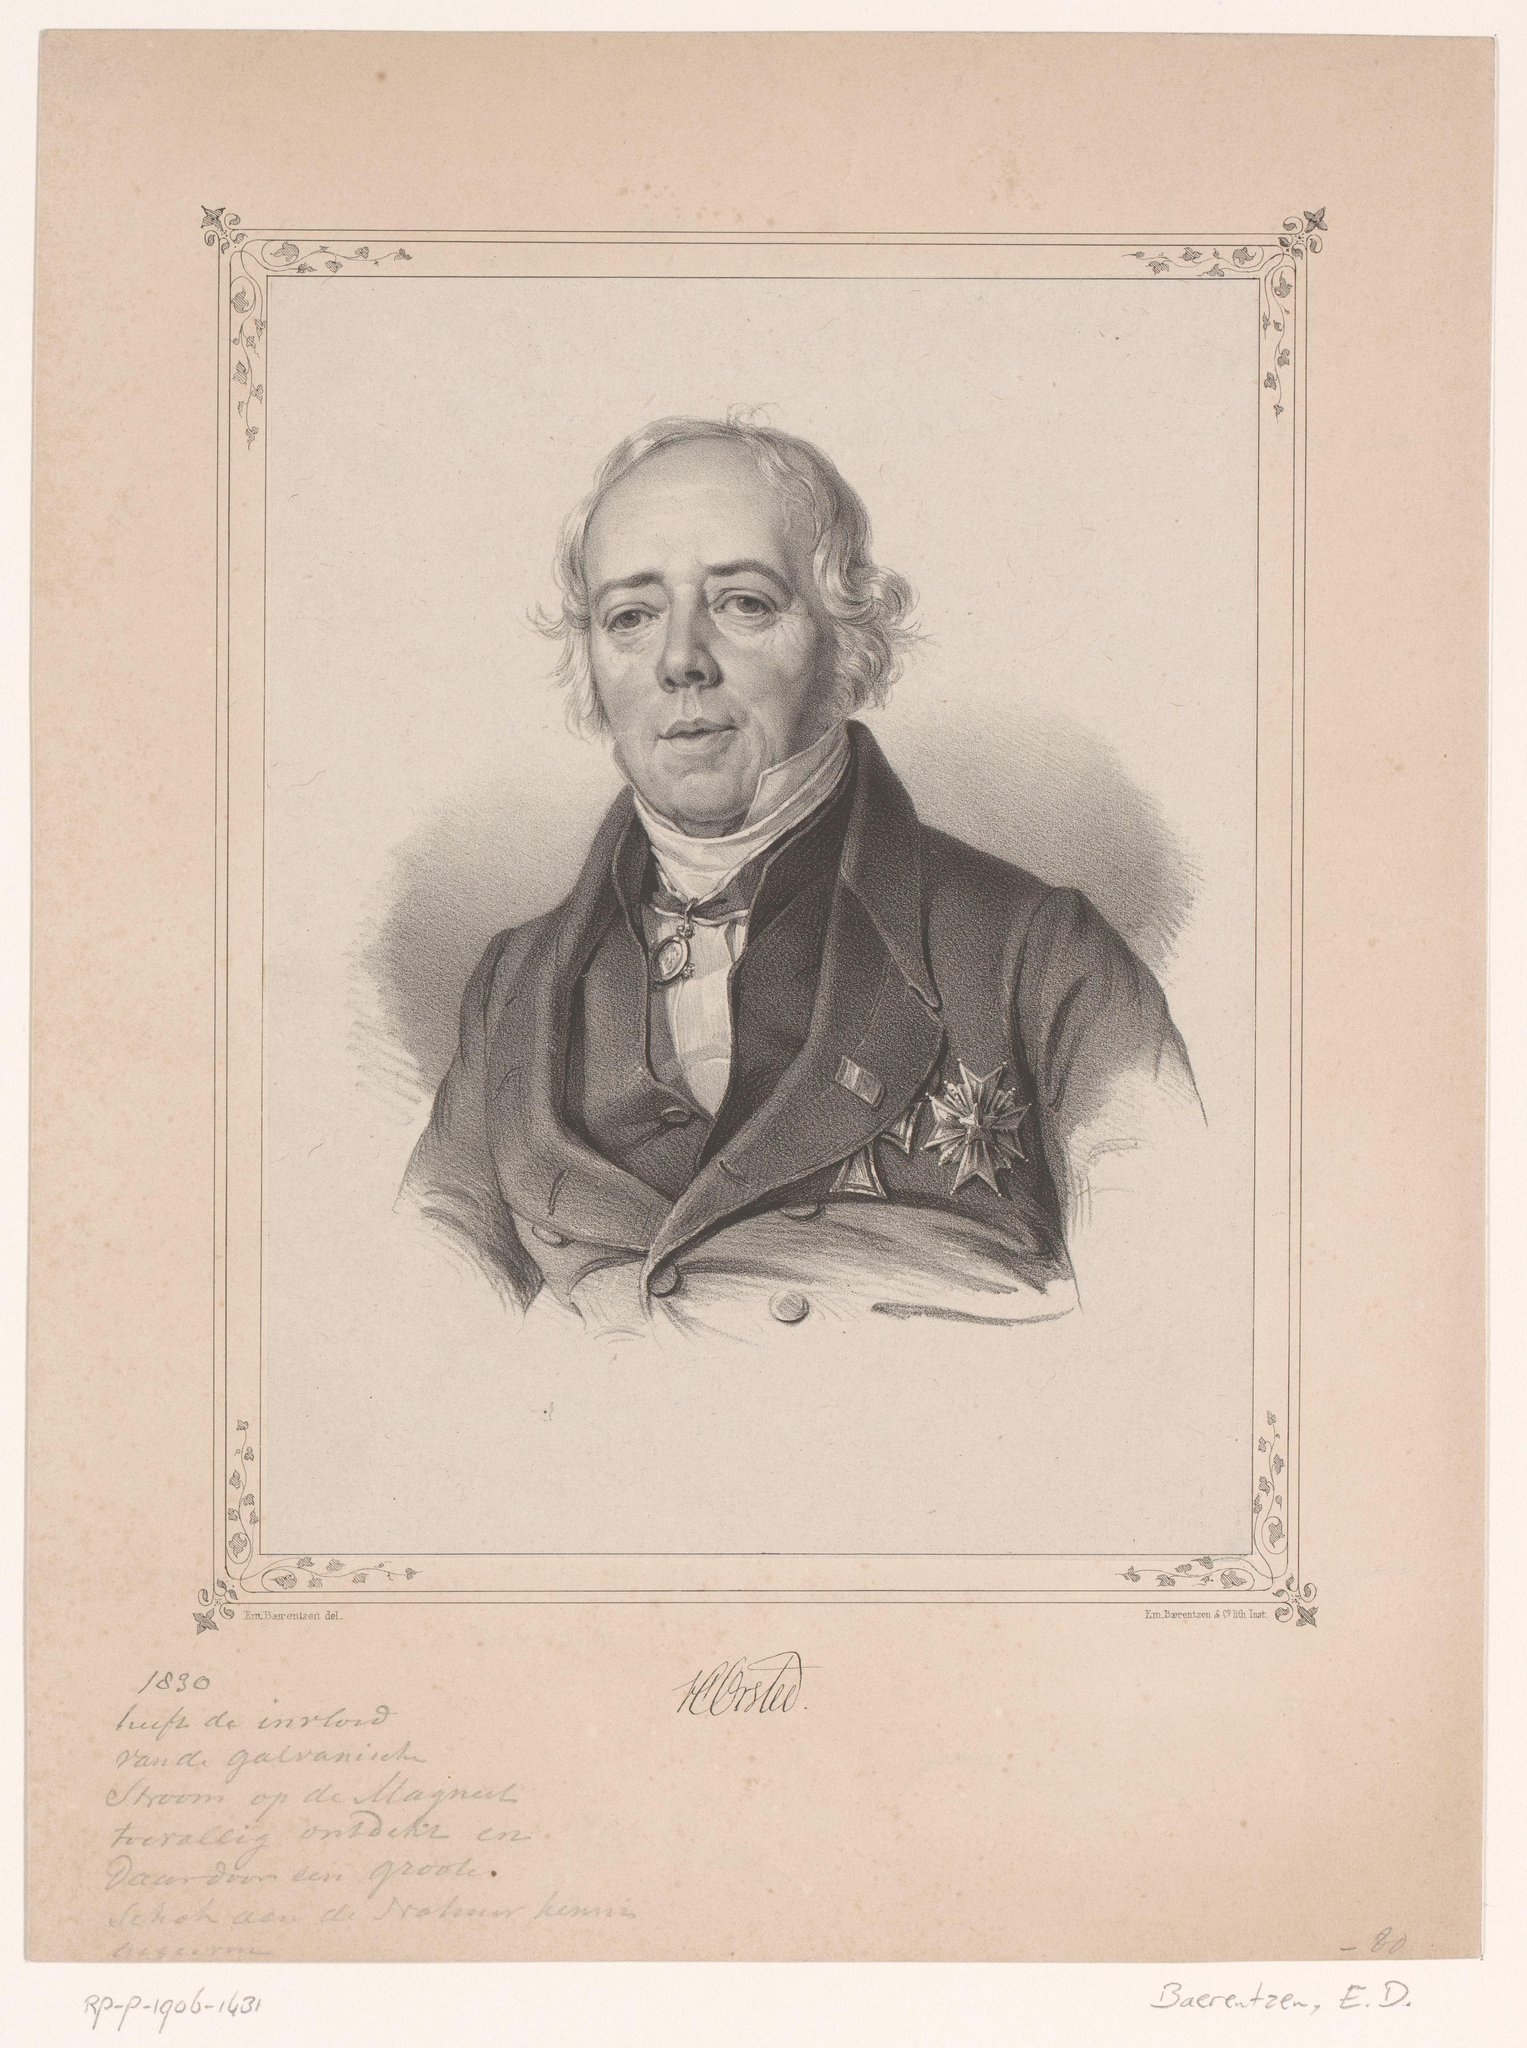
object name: print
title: Portret van Hans Christian Ørsted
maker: emilius ditlev baerentzen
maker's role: print maker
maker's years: 1799-1868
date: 1837-1868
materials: paper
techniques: lithograph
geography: copenhagen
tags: copenhagen (city), politician, historical persons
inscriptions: inscription: ‘Em. Baerentzen & Co lith.Inst.’, collector's mark: Lugt 2228, inscription: ‘Em. Baerentzen del.’, inscription: ‘HCOrsted.’